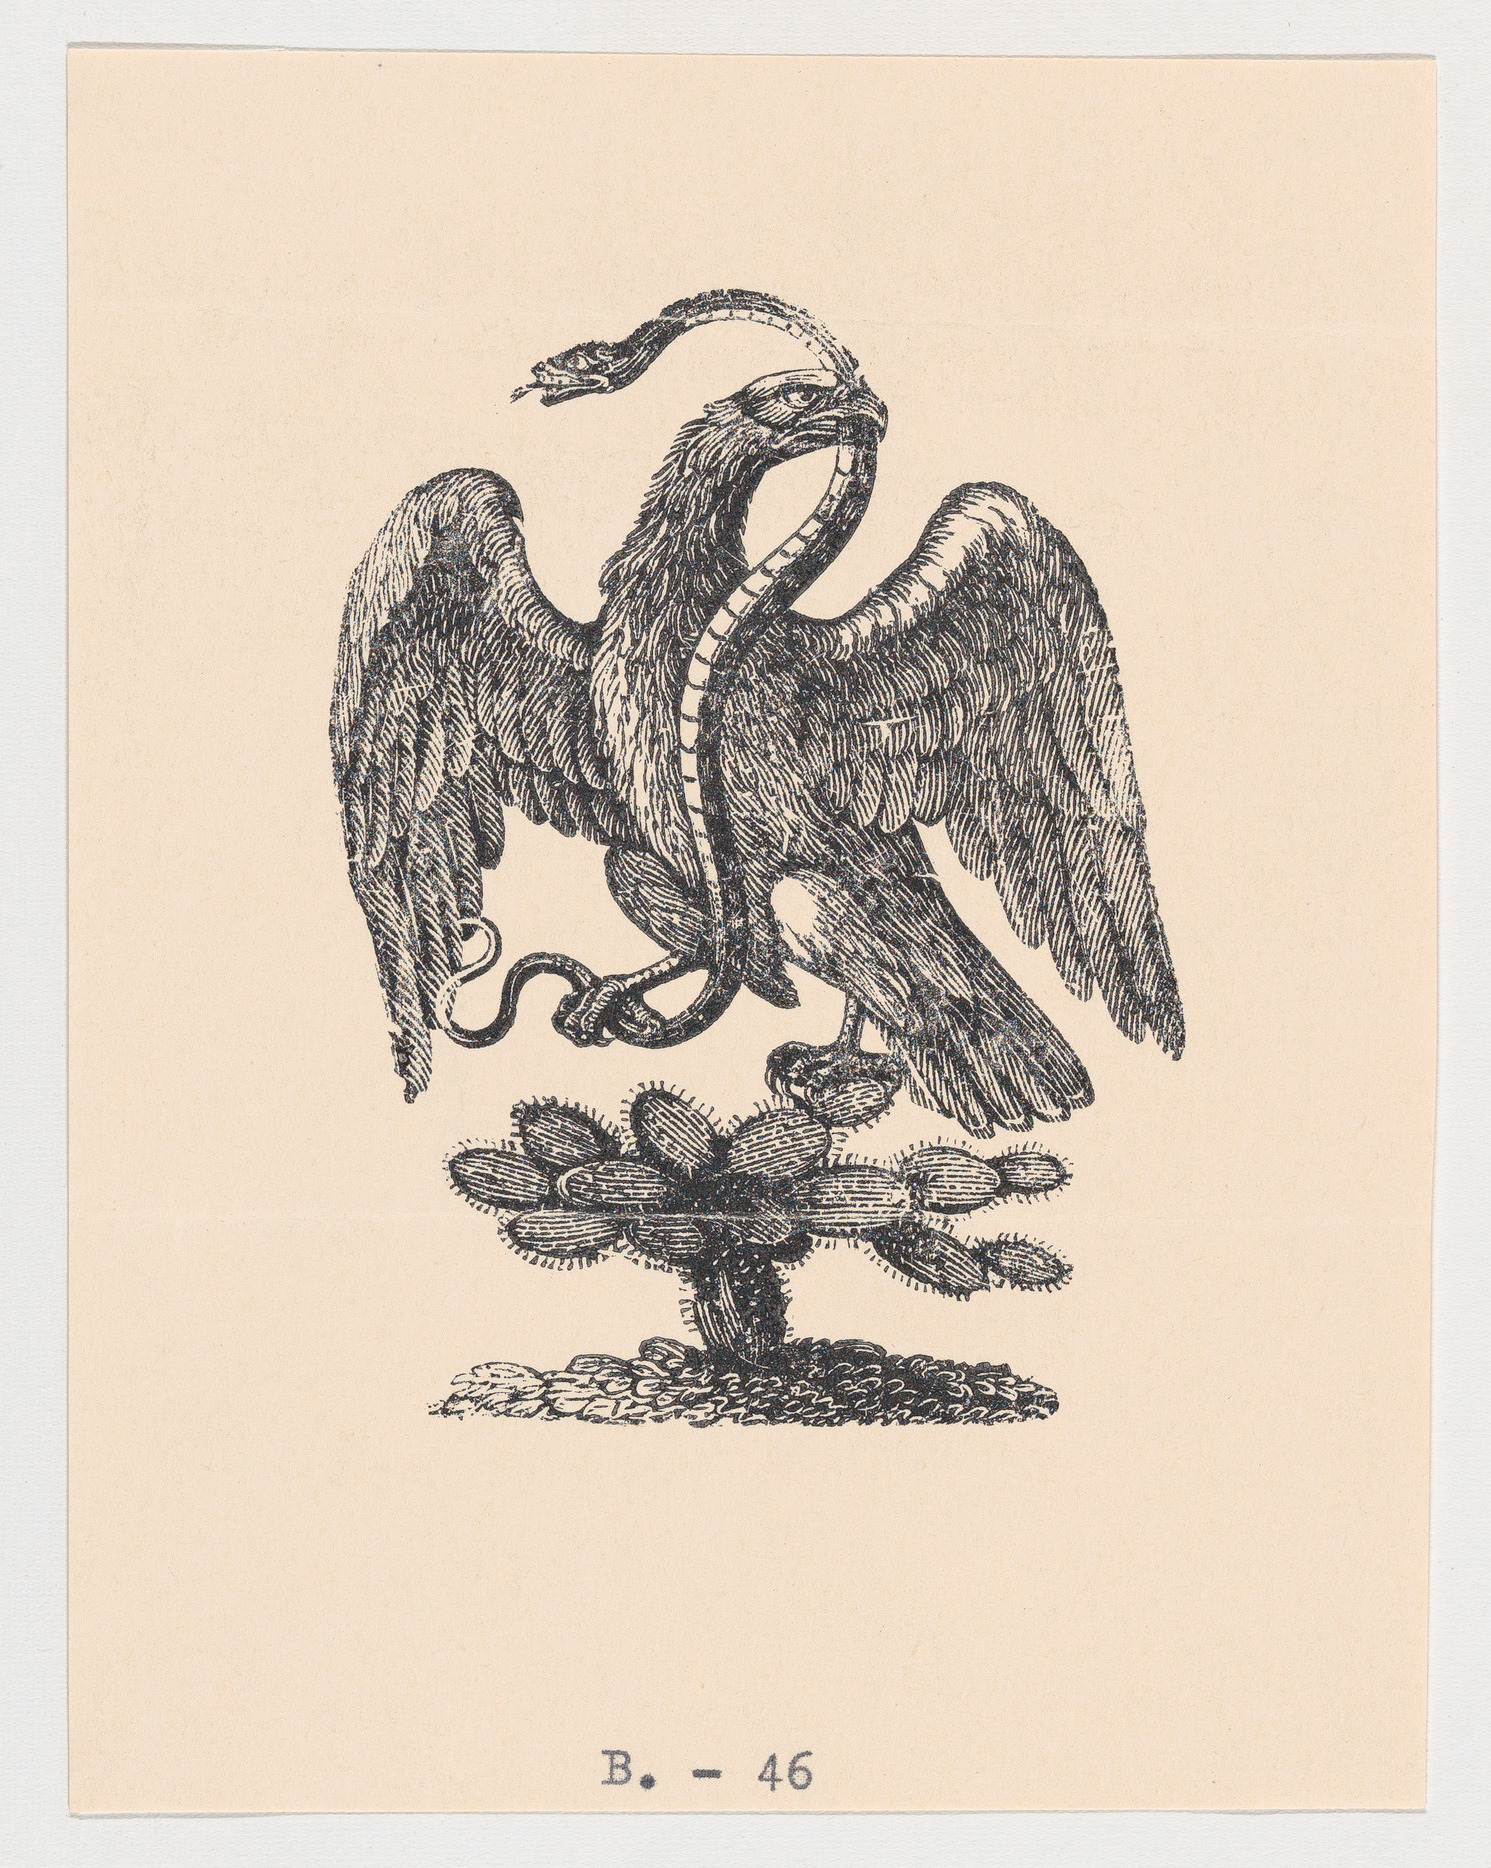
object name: print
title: An eagle resting on a cactus holding a snake in its beak (from the Mexican coat of arms)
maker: Anonymous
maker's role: artist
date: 1900-1910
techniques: lithography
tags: eagles,snakes,plants